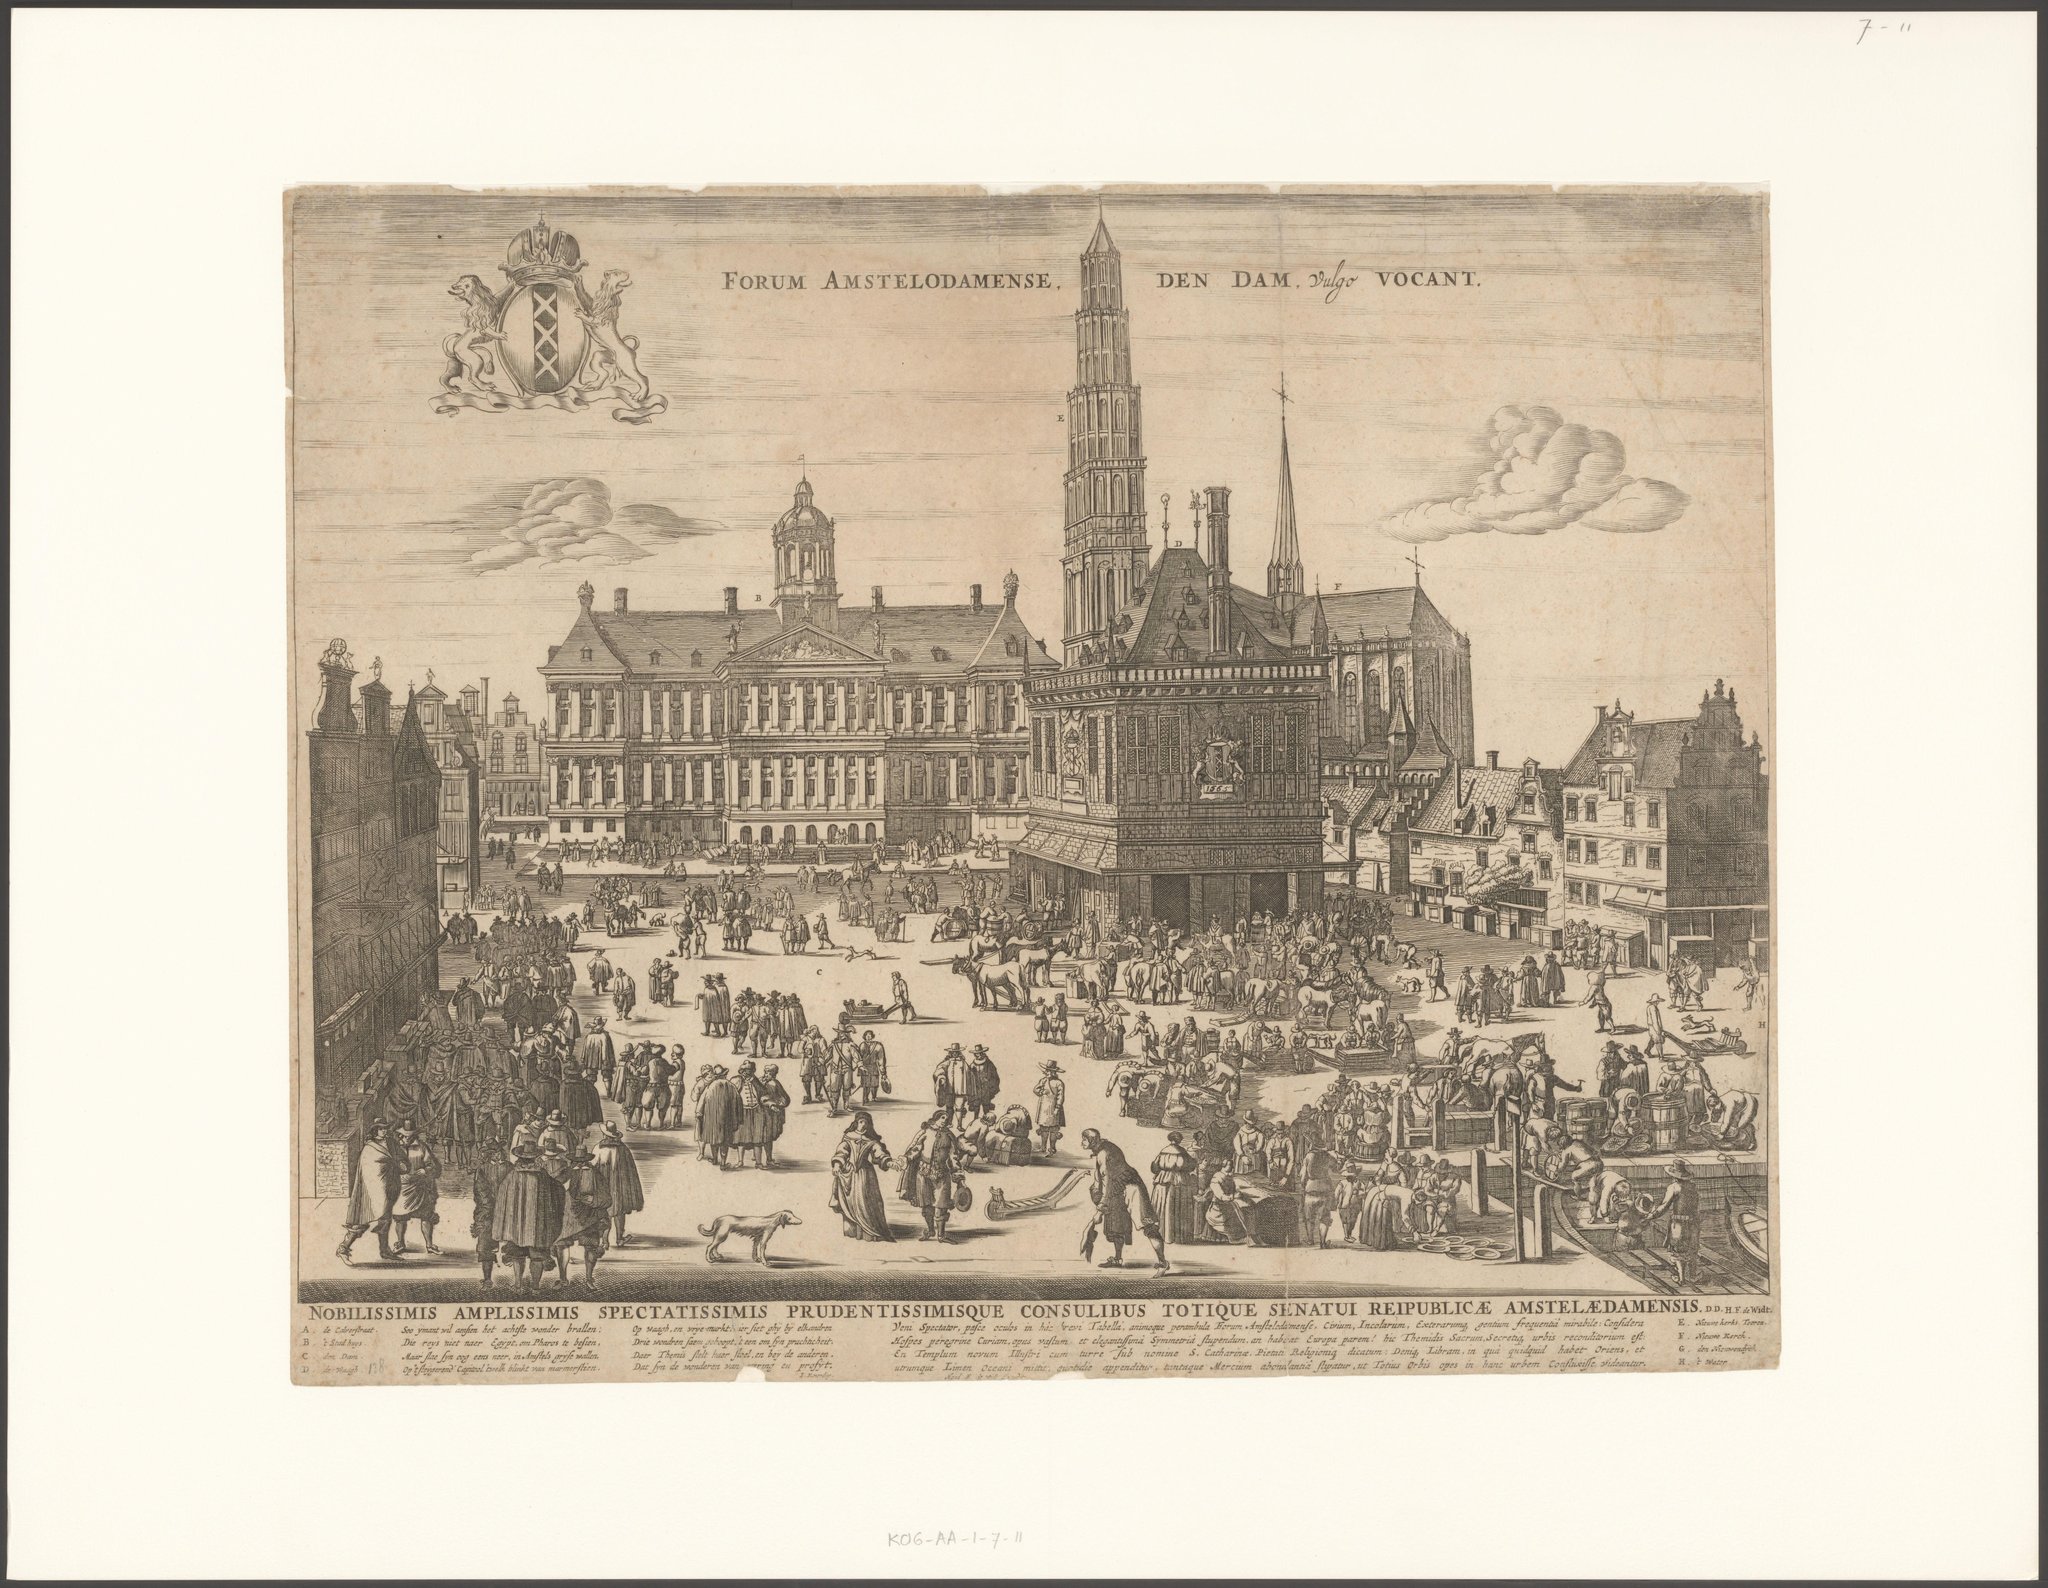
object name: print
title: Gezicht op het Stadhuis, de Nieuwe Kerk en de Waag op de Dam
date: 1639-1706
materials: paper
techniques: engraving, etching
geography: amsterdam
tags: square, place, circus, etc., city-view in general; 'veduta', church (exterior), townhall, weigh-house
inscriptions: name: ‘I Konerding’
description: Onderwerpsrubriek binnen de Atlas Amsterdam: Dam (voor 1835).